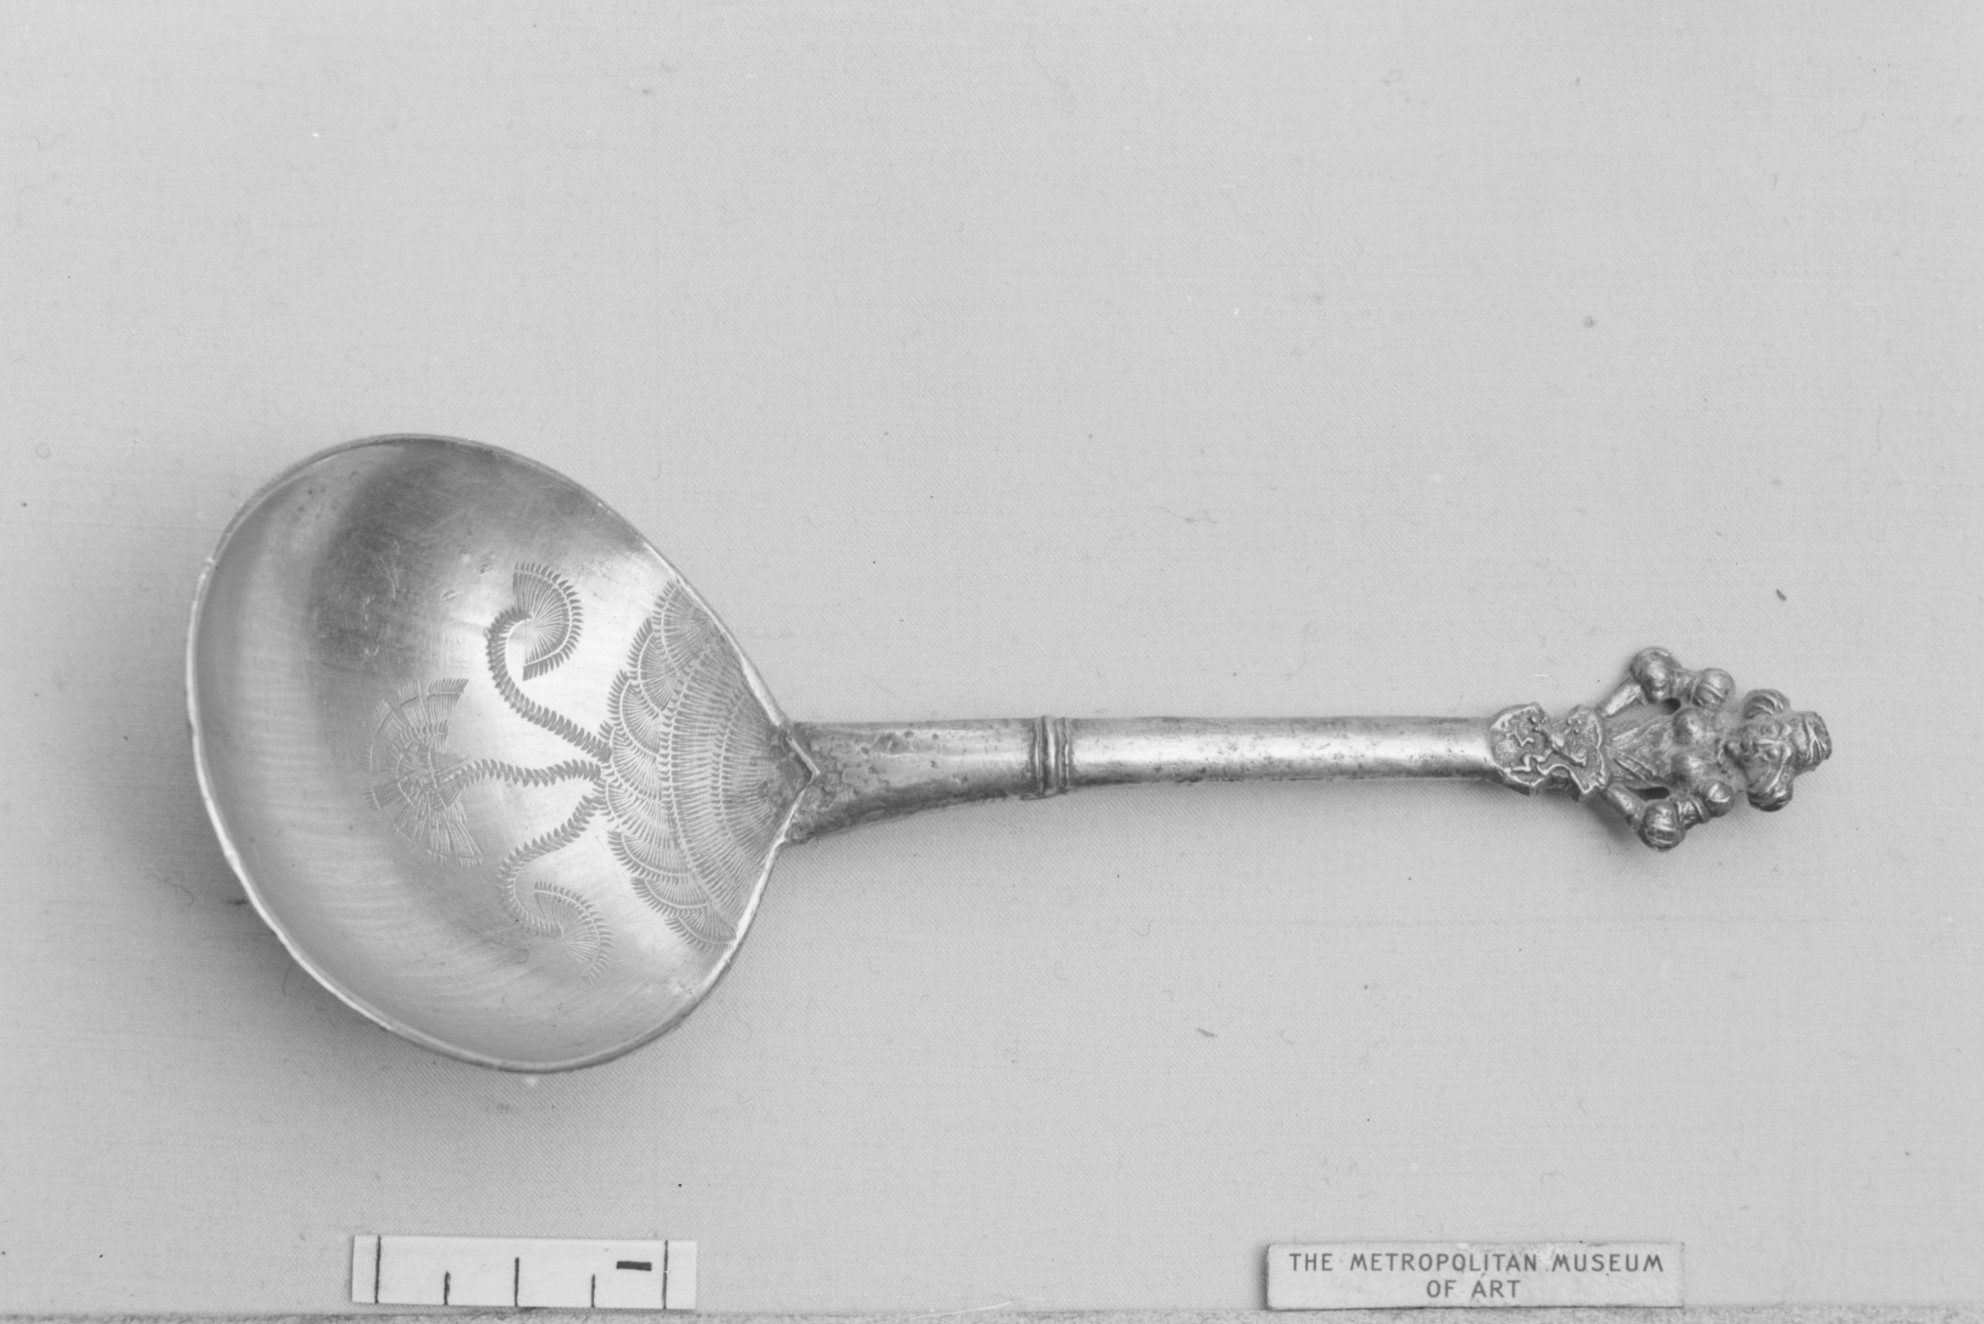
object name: spoon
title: Figure-top spoon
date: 1501-1533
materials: pewter